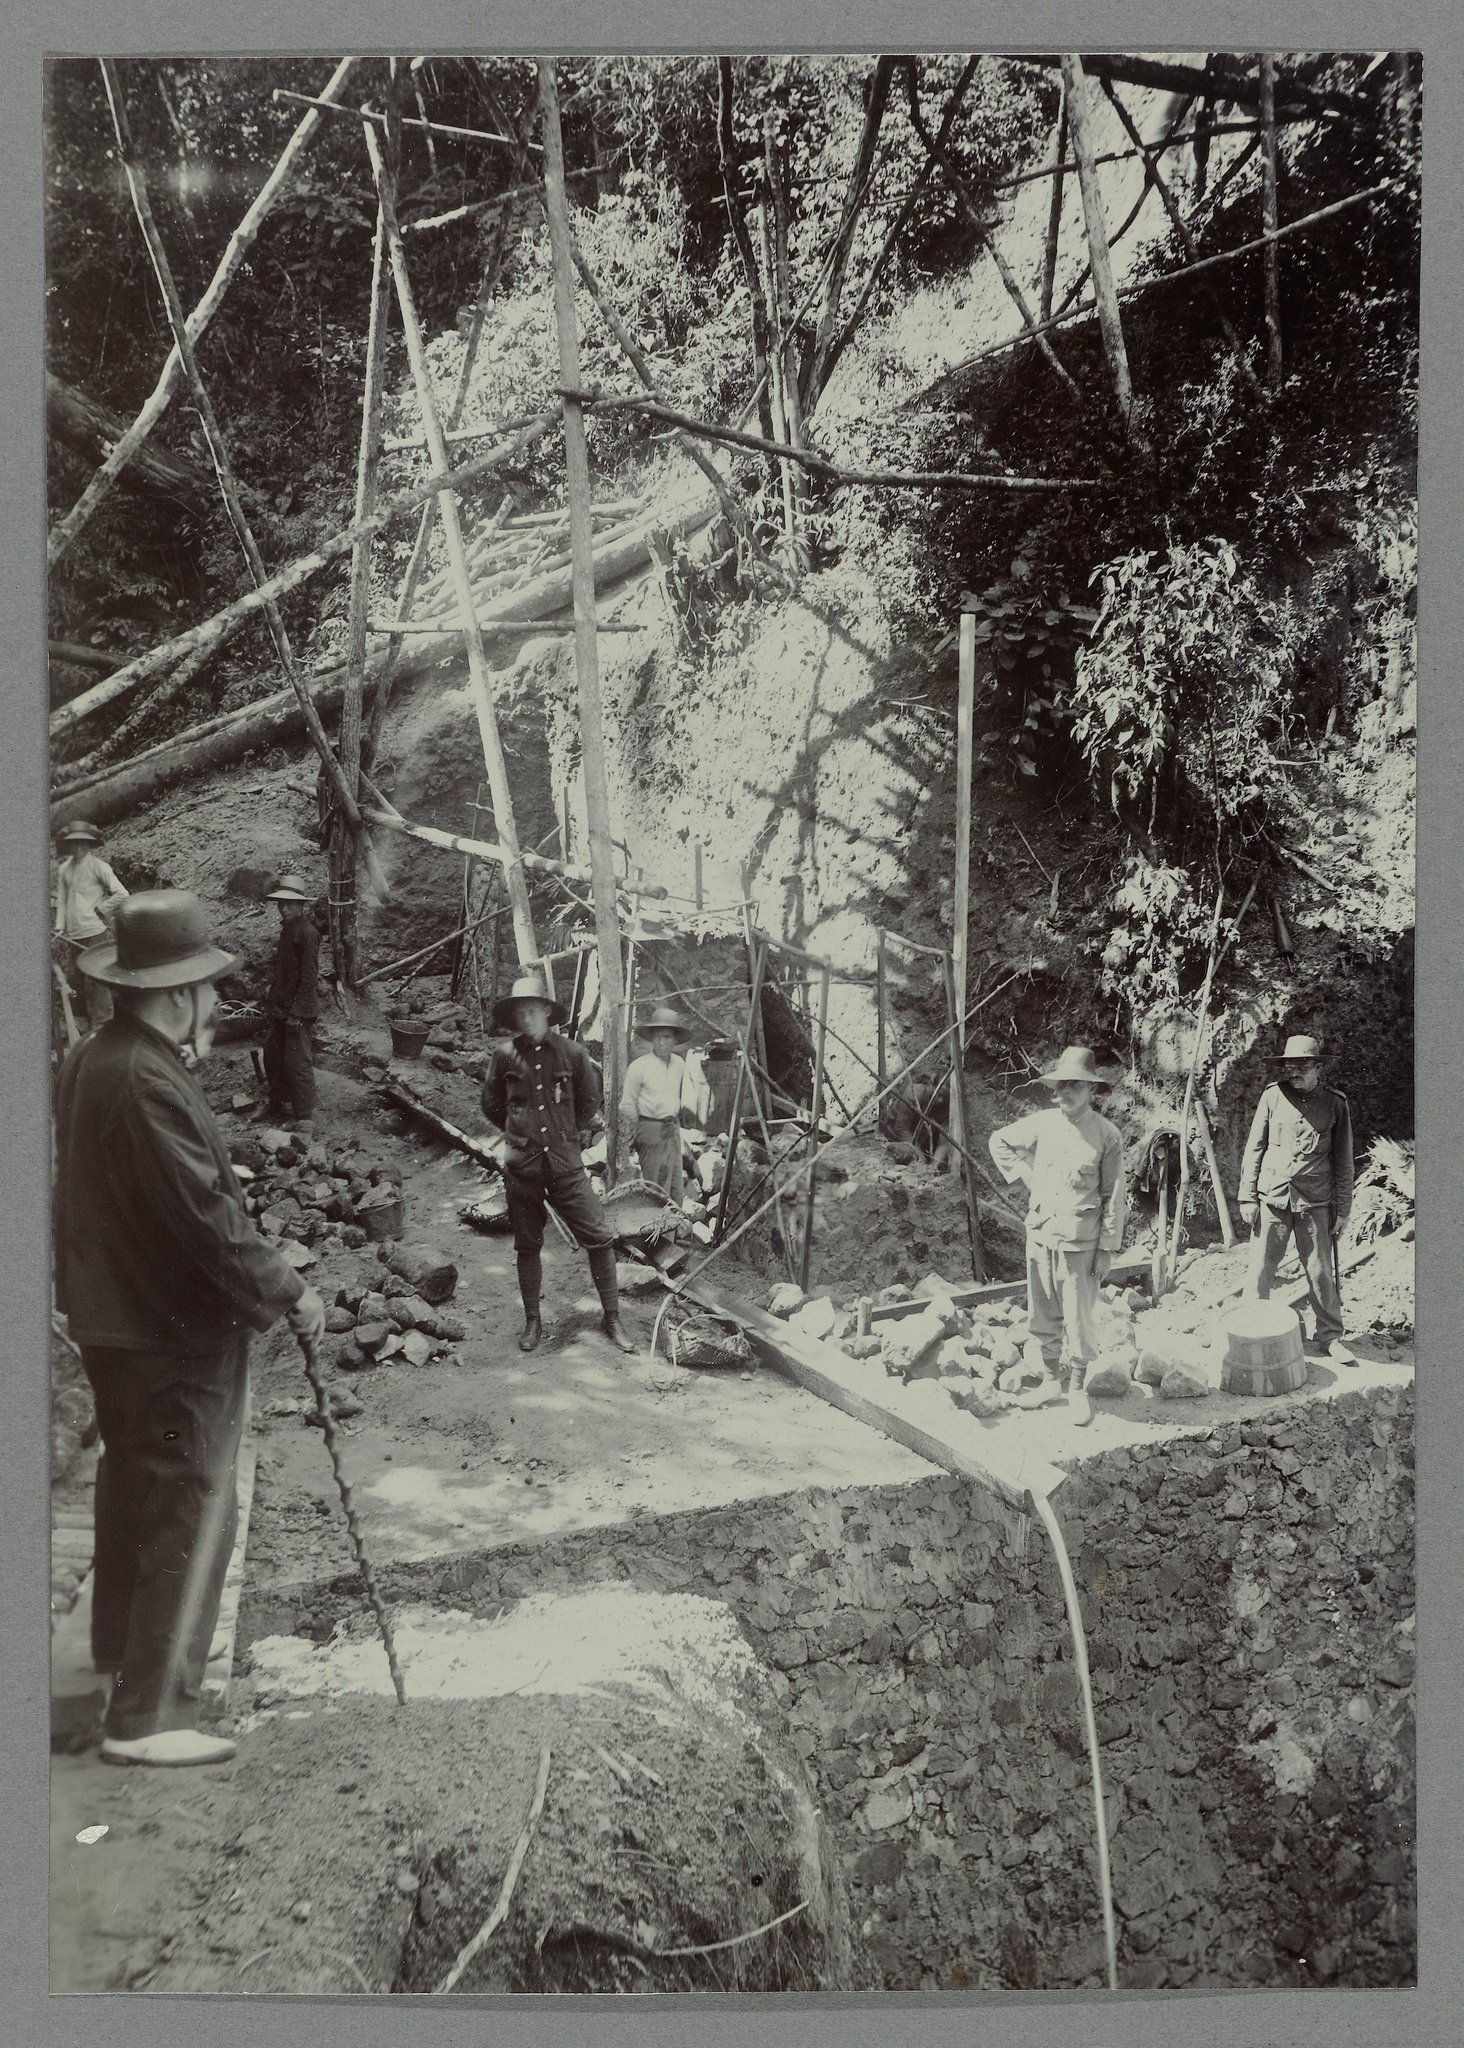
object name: photograph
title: Bouw van een brug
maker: Anonymous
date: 1903-1913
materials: photographic support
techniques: photography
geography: north sumatra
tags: arnhem, the hague, albertus dominicus laman trip, landscapes in tropical and sub-tropical regions, bridge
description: Na de expedities naar de Gajo- en Alaslanden o.l.v. Van Daalen (eerste tocht in 1901), werd hij in 1903 belast met voorbereiding van permanente vestiging van Nederlands gezag. Aanleg van een weg van de Noordkust naar het binnenland was hierbij van groot belang. Deze zgn. Gajoweg werd aangelegd tussen 1903 en 1914, van Bireuen aan de kust naar Takinguen aan het bergmeer Danau Lauttawar, totale lente 104 km.